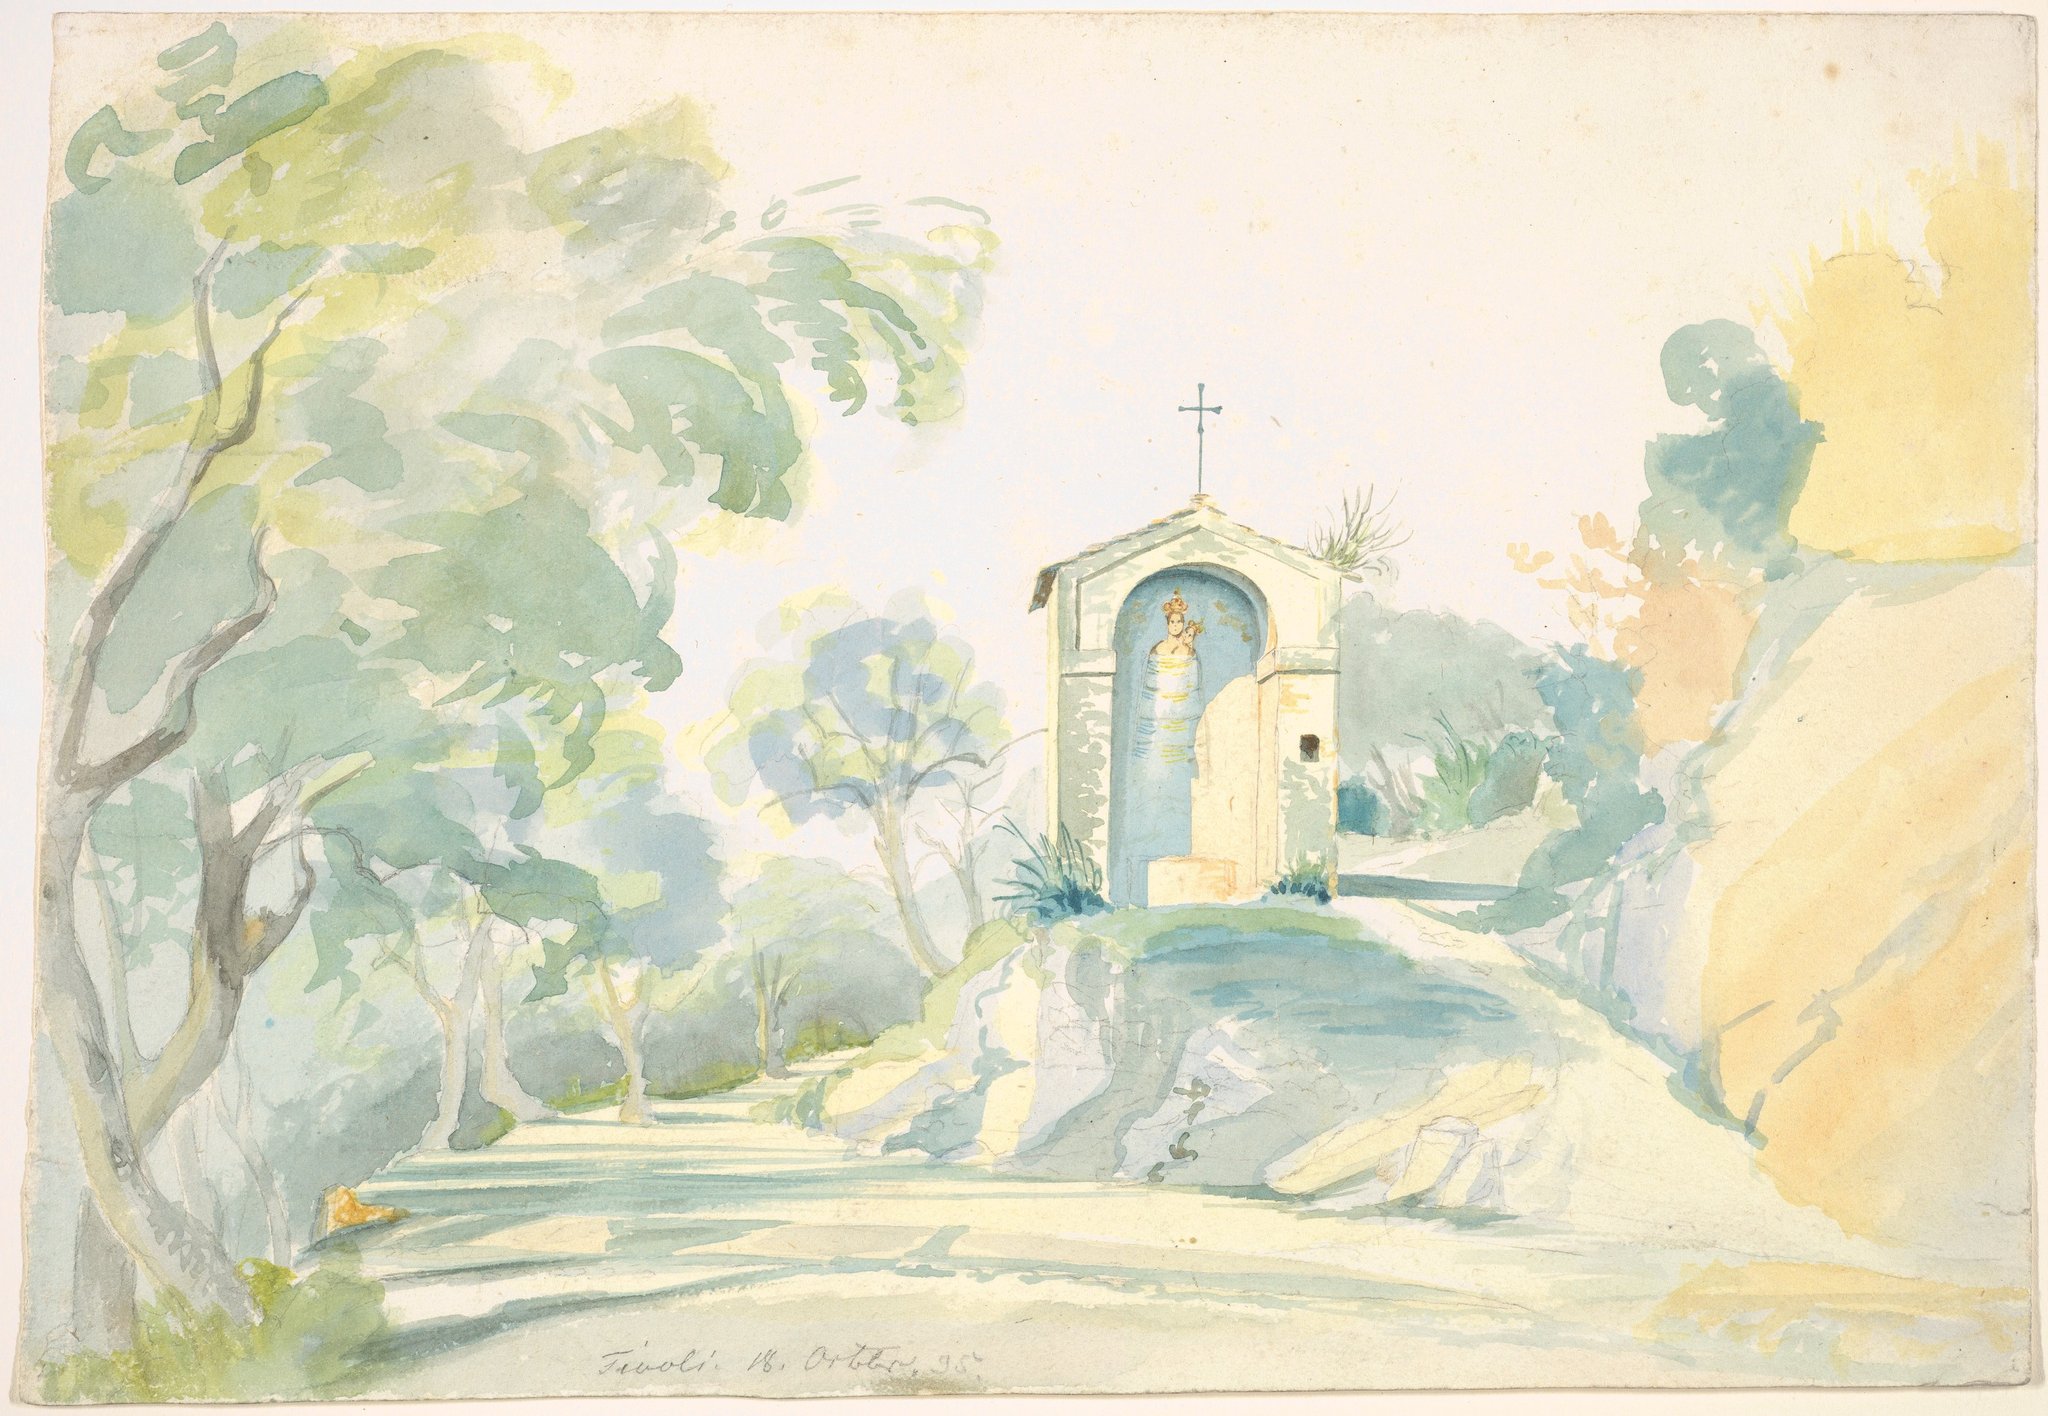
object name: drawing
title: A Roadside Chapel near Tivoli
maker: august georg friedrich lucas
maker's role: artist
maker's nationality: german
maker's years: 1803-1863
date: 1835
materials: graphite, watercolor